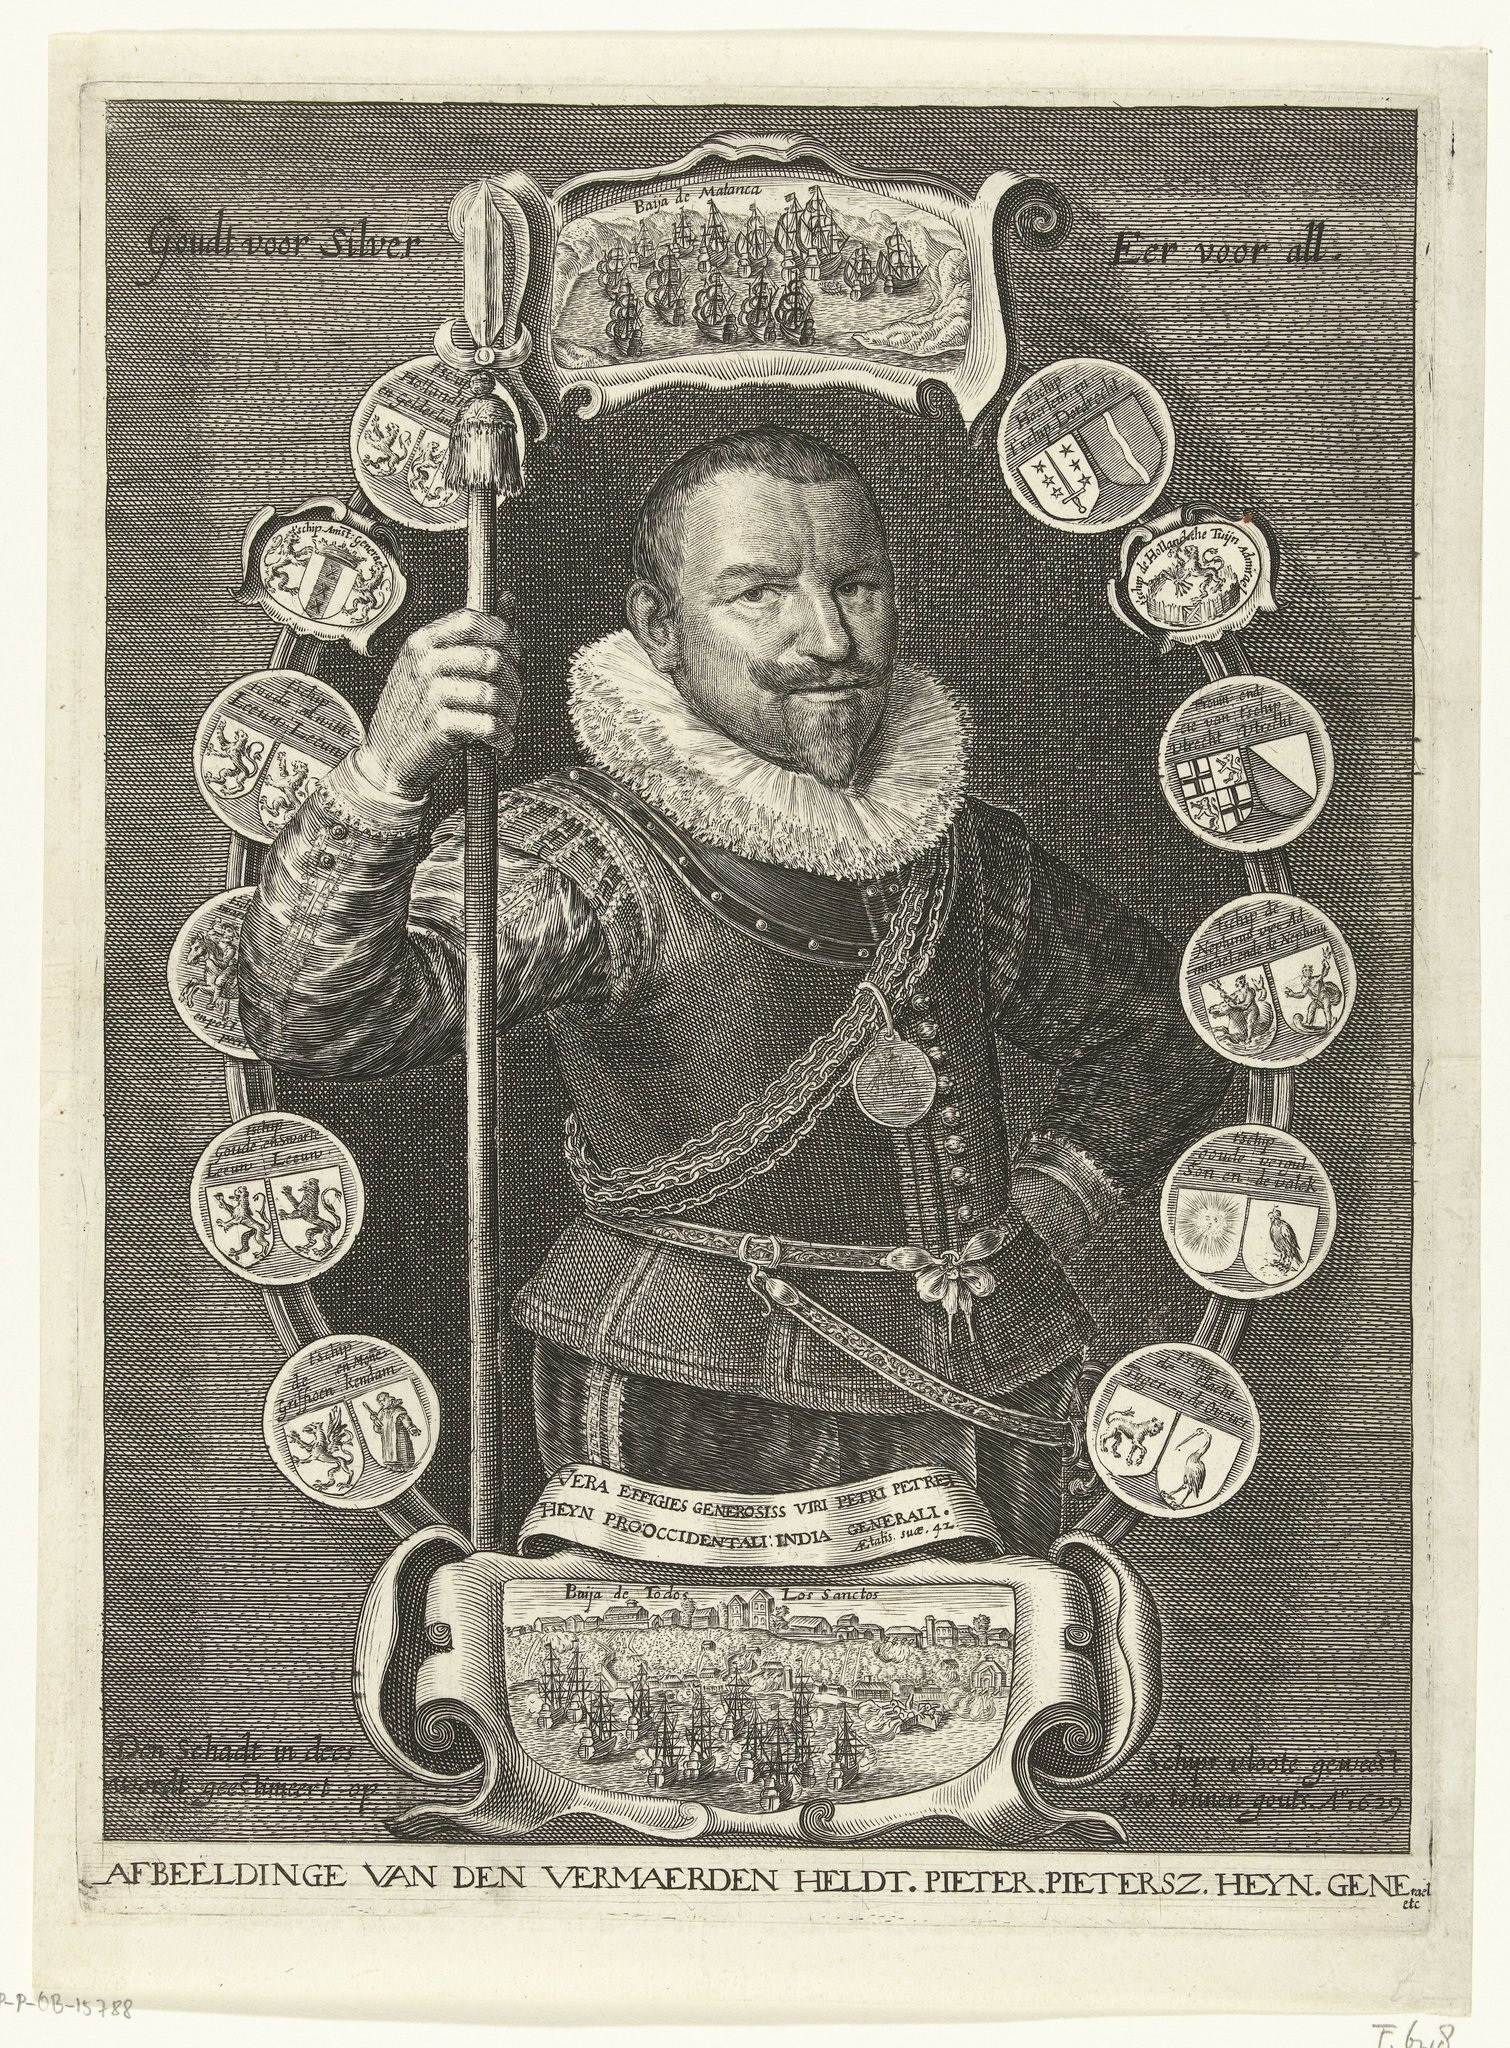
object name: print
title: Portret van Piet Hein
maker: crispijn van de passe (ii)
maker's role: draughtsman, print maker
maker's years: 1594-1670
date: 1629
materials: paper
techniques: engraving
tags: delfshaven, battle (+ naval force), capture of the spanish treasure fleet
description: Portret van admiraal Piet Hein, staande ten halven lijve, linkerhand in de zij, in de rechterhand een lans. In een ovaal gevormd door medaillons met wapens. Bovenaan de verovering van de Zilvervloot (1628), onderaan de overwinning bij São Salvador de Bahia de Todos os Santos (1627).